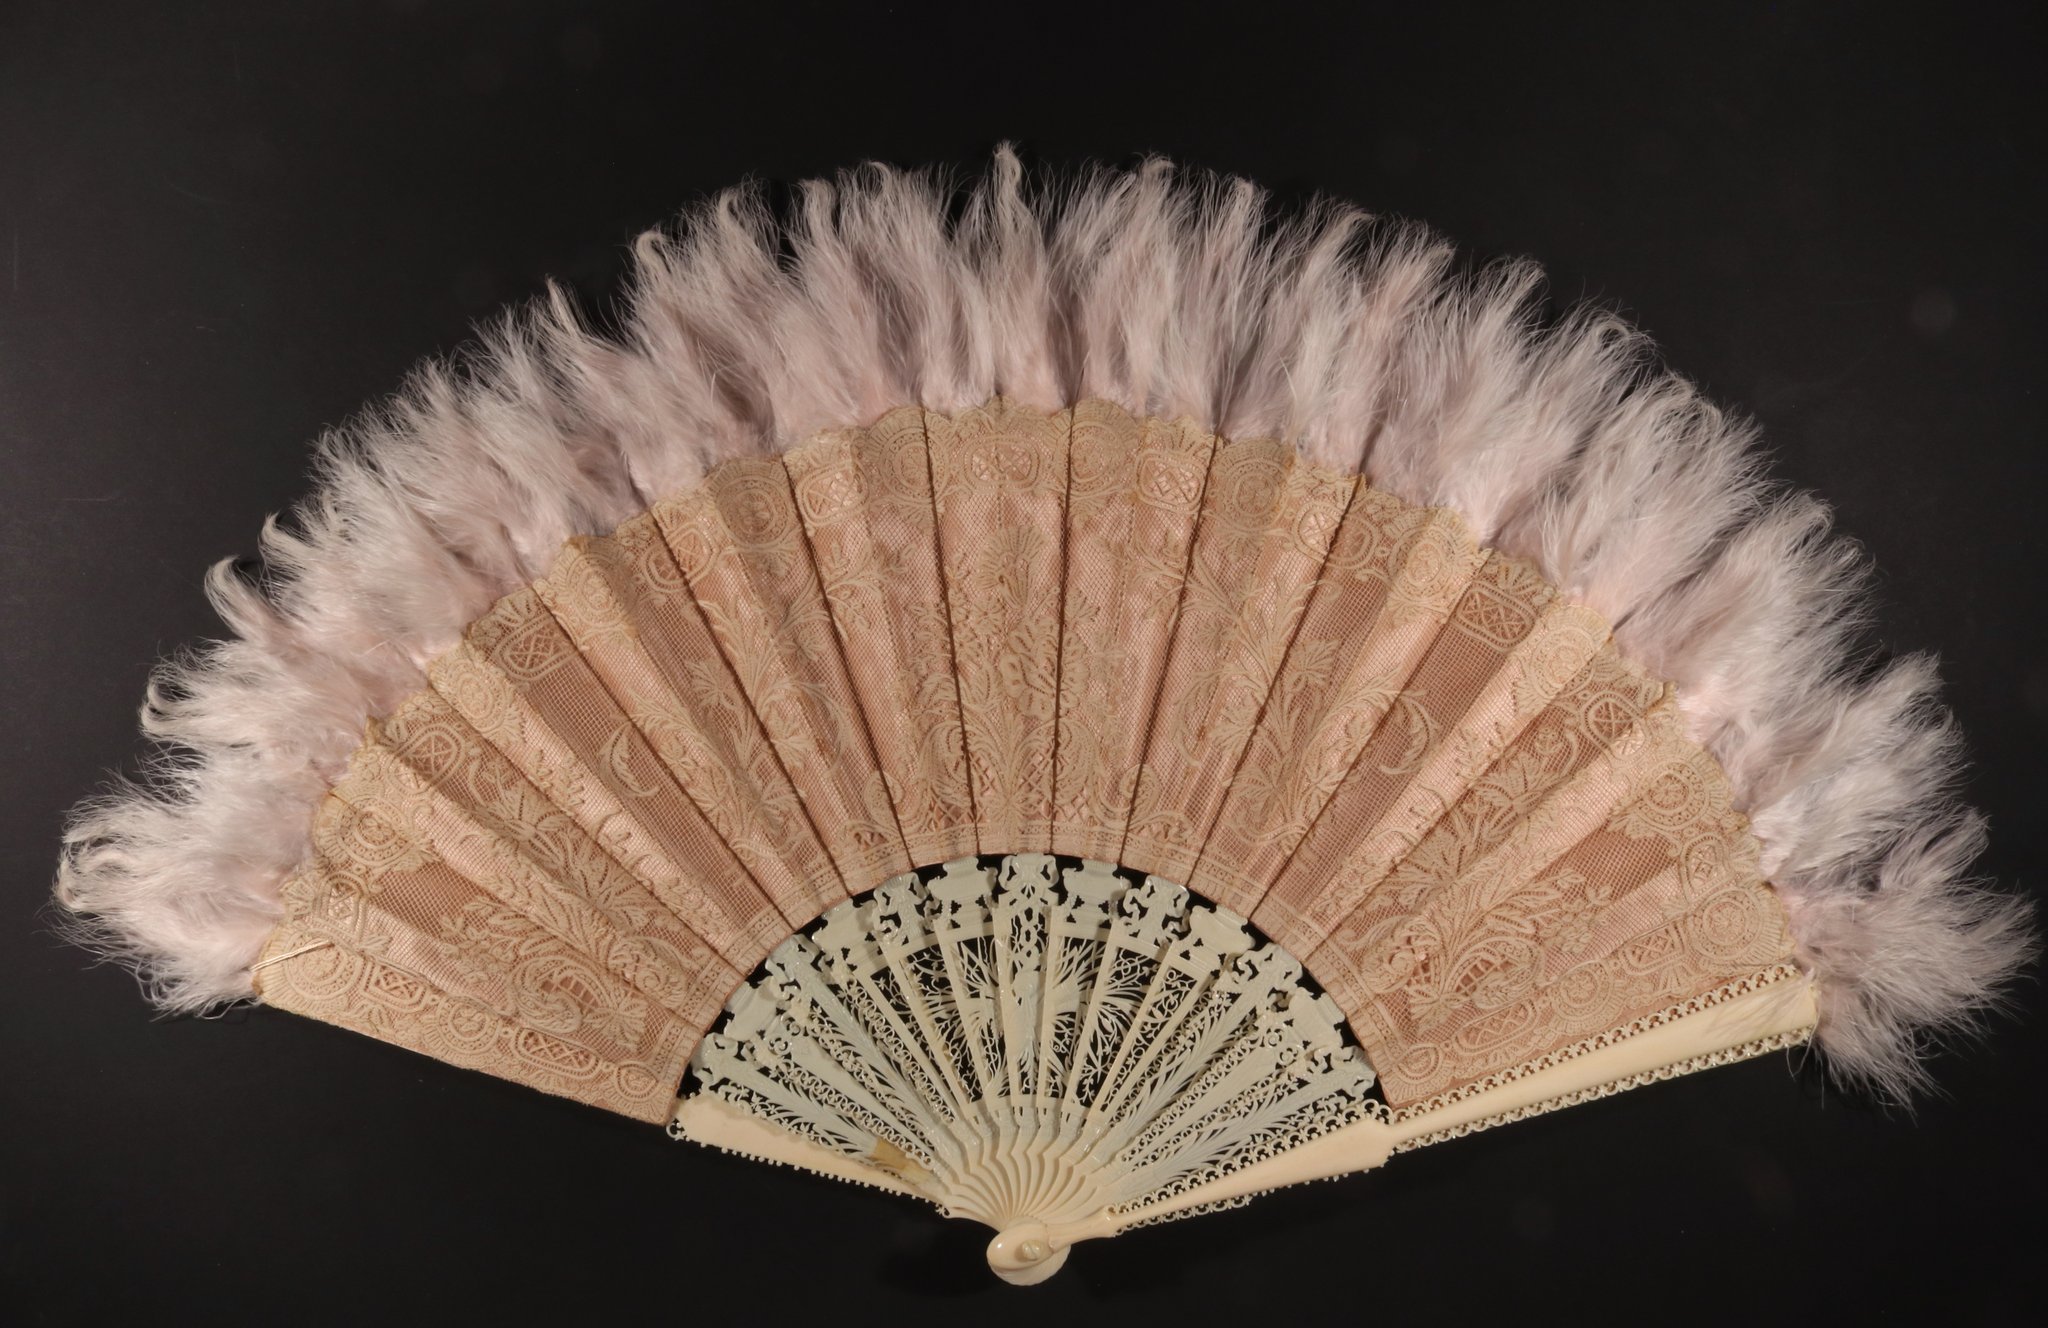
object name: fan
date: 1867-1900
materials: feather, ivory, lace, paper, textile